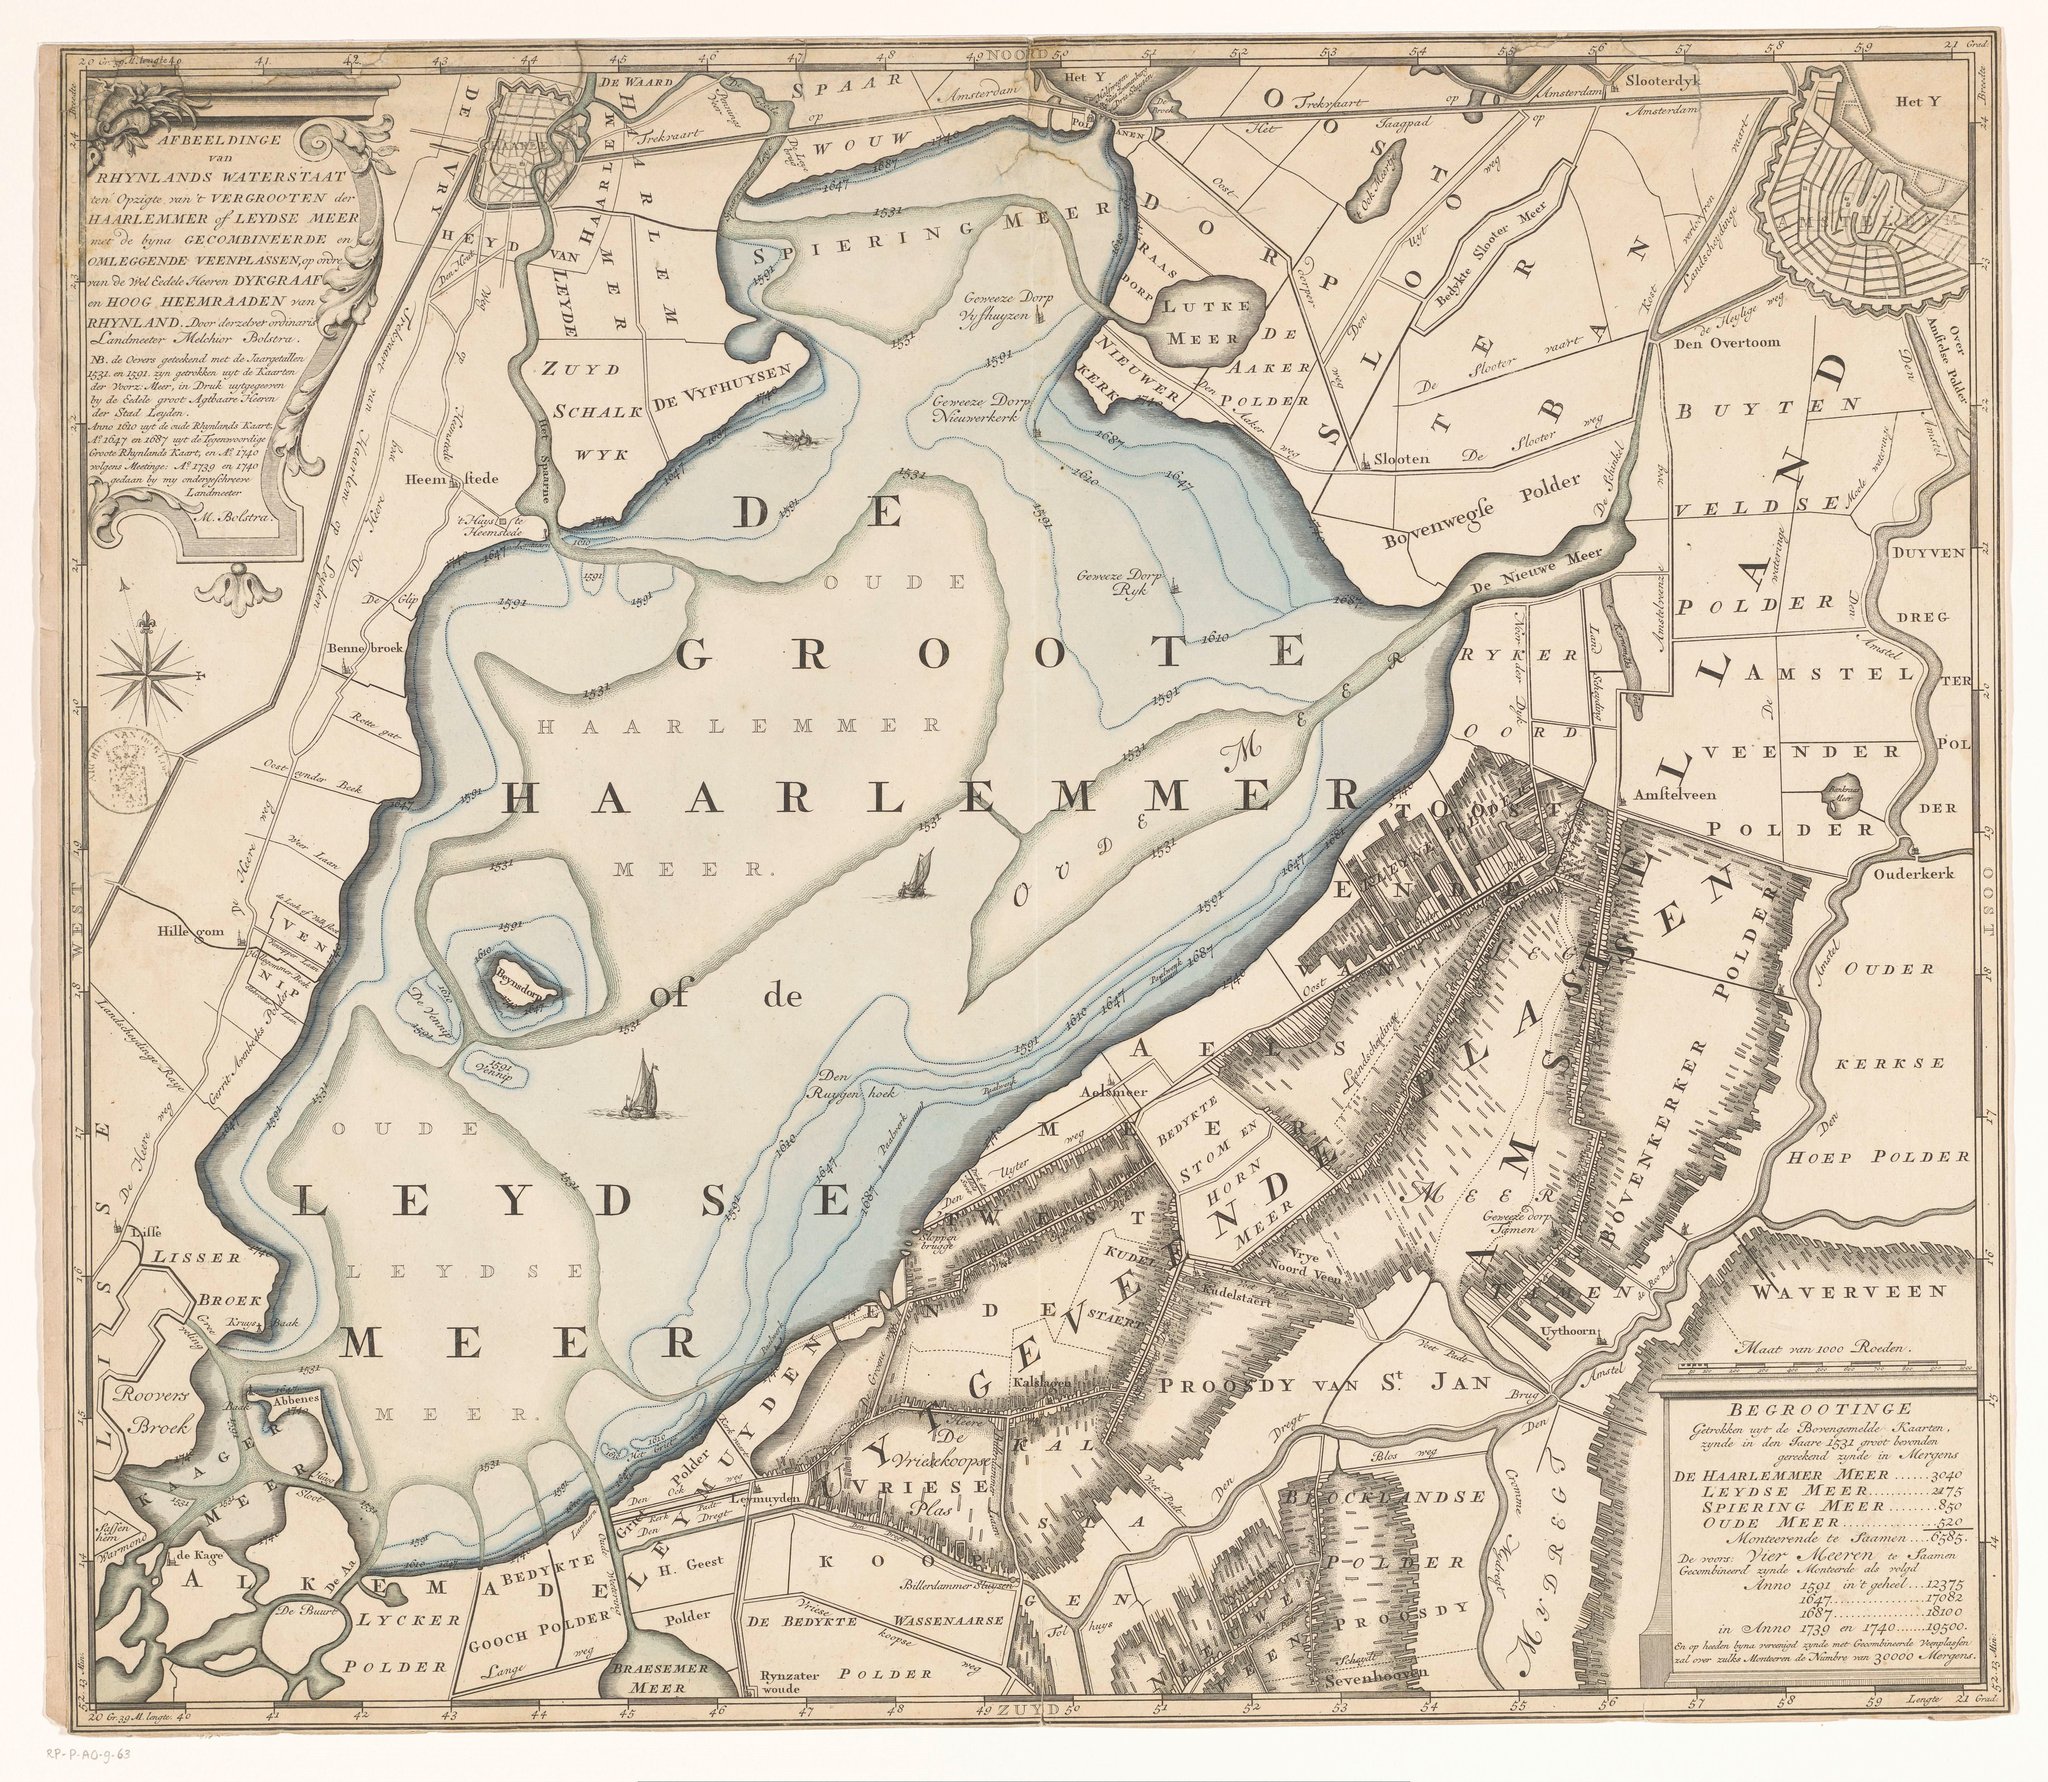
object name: map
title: Kaart van het Haarlemmermeer en omliggende gebieden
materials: paper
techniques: engraving, etching, hand coloring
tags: maps of separate countries or regions, haarlem, amsterdam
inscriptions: collector's mark: Lugt 19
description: Kaart van het Haarlemmermeer en omliggende gebieden. Linksboven de titelcartouche. Rechtsonder een cartouche met informatie, daarboven een schaalstok: Maat van 1000 roeden. Gradenverdeling langs de randen.